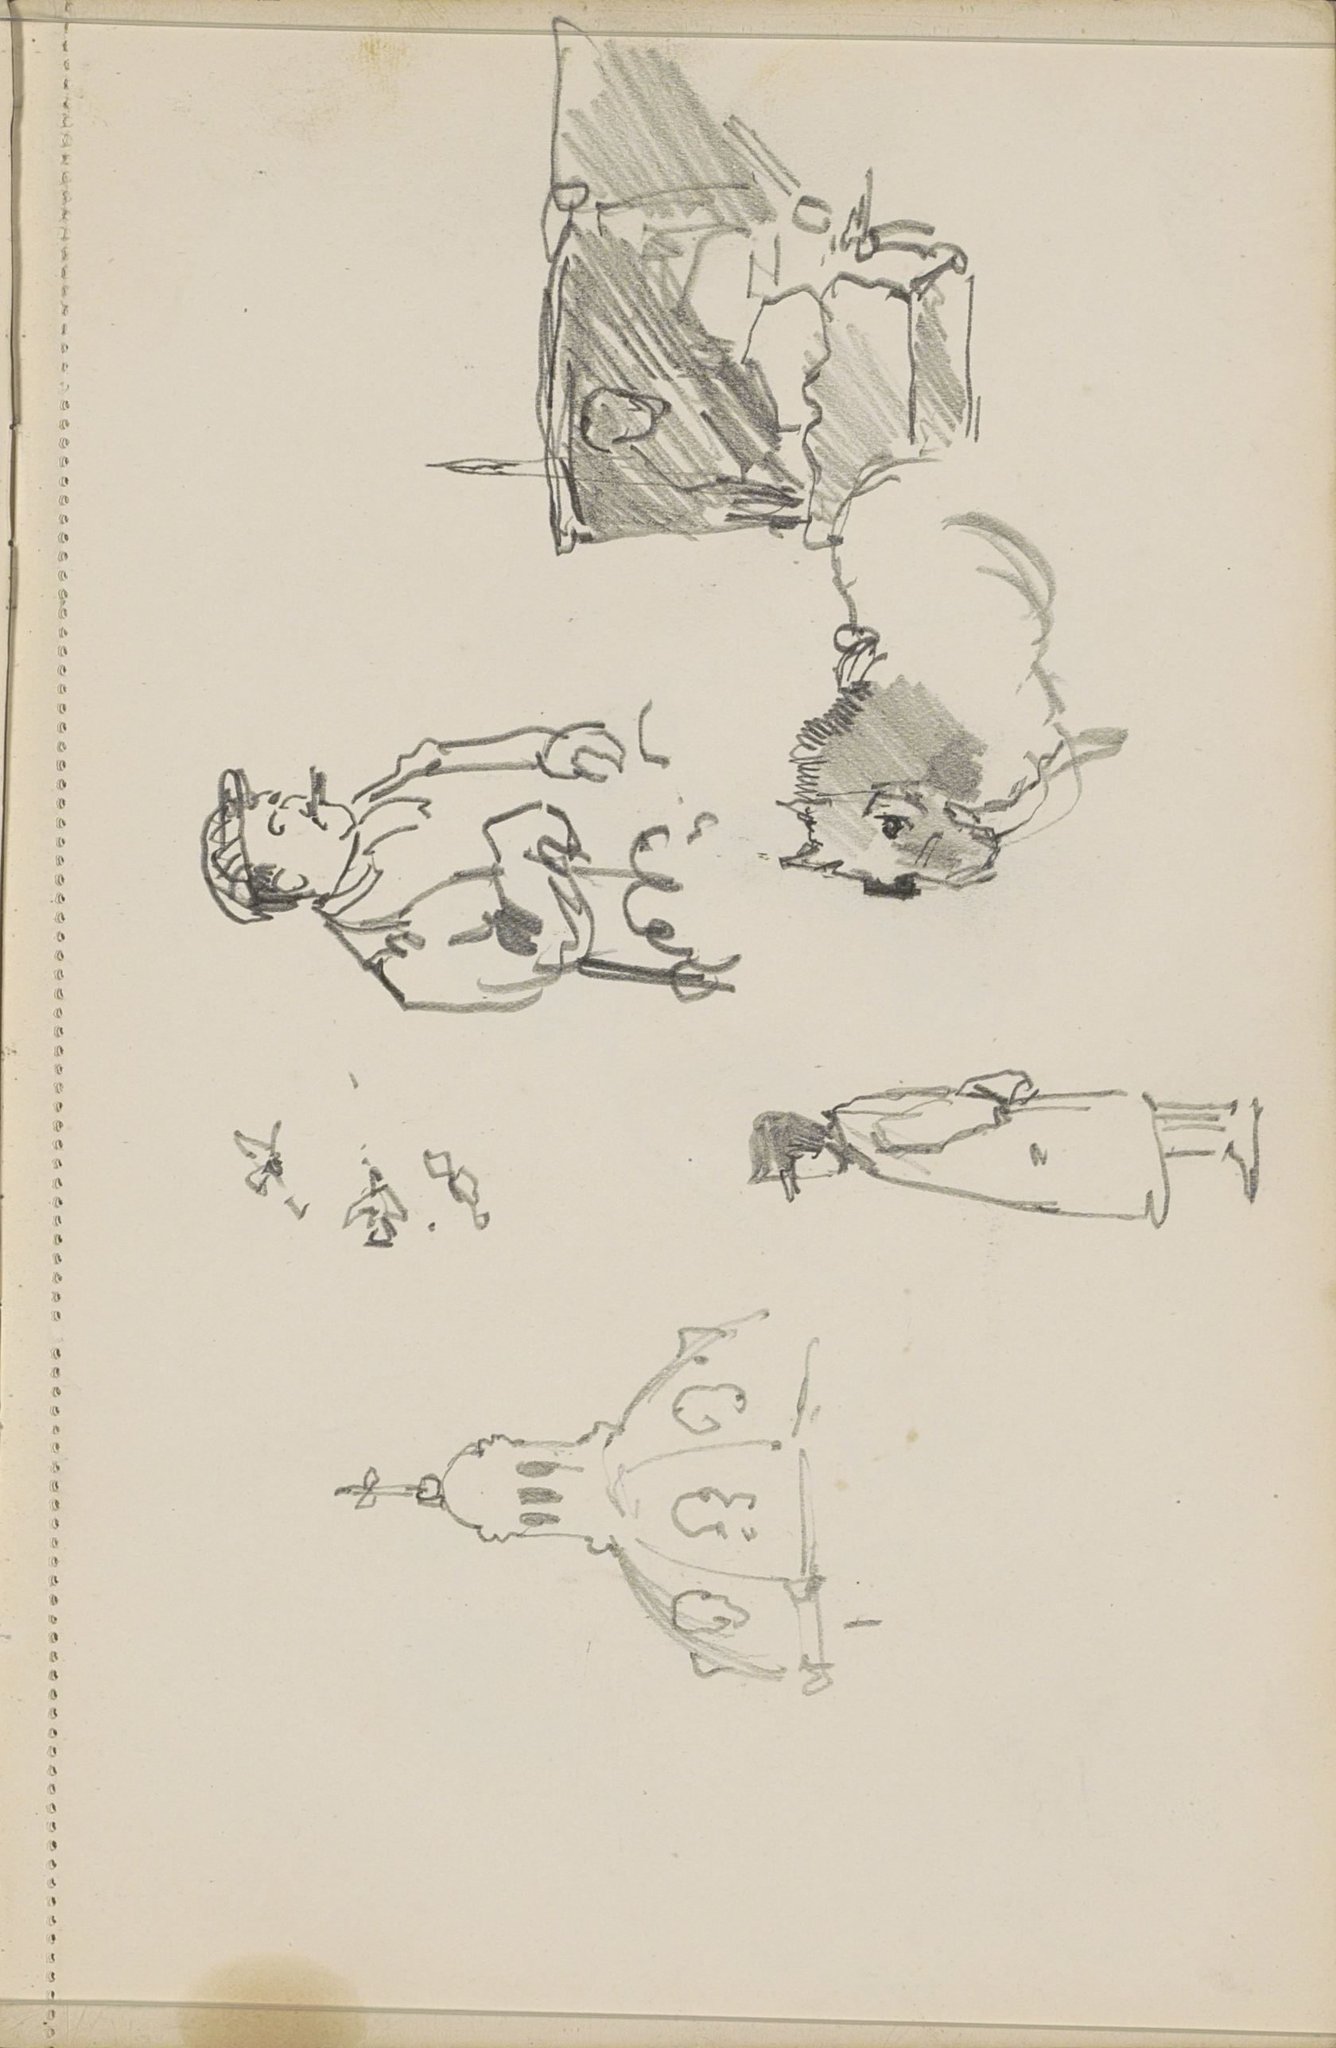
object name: sketchbook leaf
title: Studieblad, onder andere met een koepeldak en paard en wagen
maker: cornelis vreedenburgh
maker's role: draughtsman, print maker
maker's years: 1880-1946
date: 1890-1946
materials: paper, pencil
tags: animal traction, animal-drawn vehicle (carriage etc.), dome ~ architecture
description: Tevens figuurstudies en vogels. Blad 10 recto uit een schetsboek met 59 bladen.